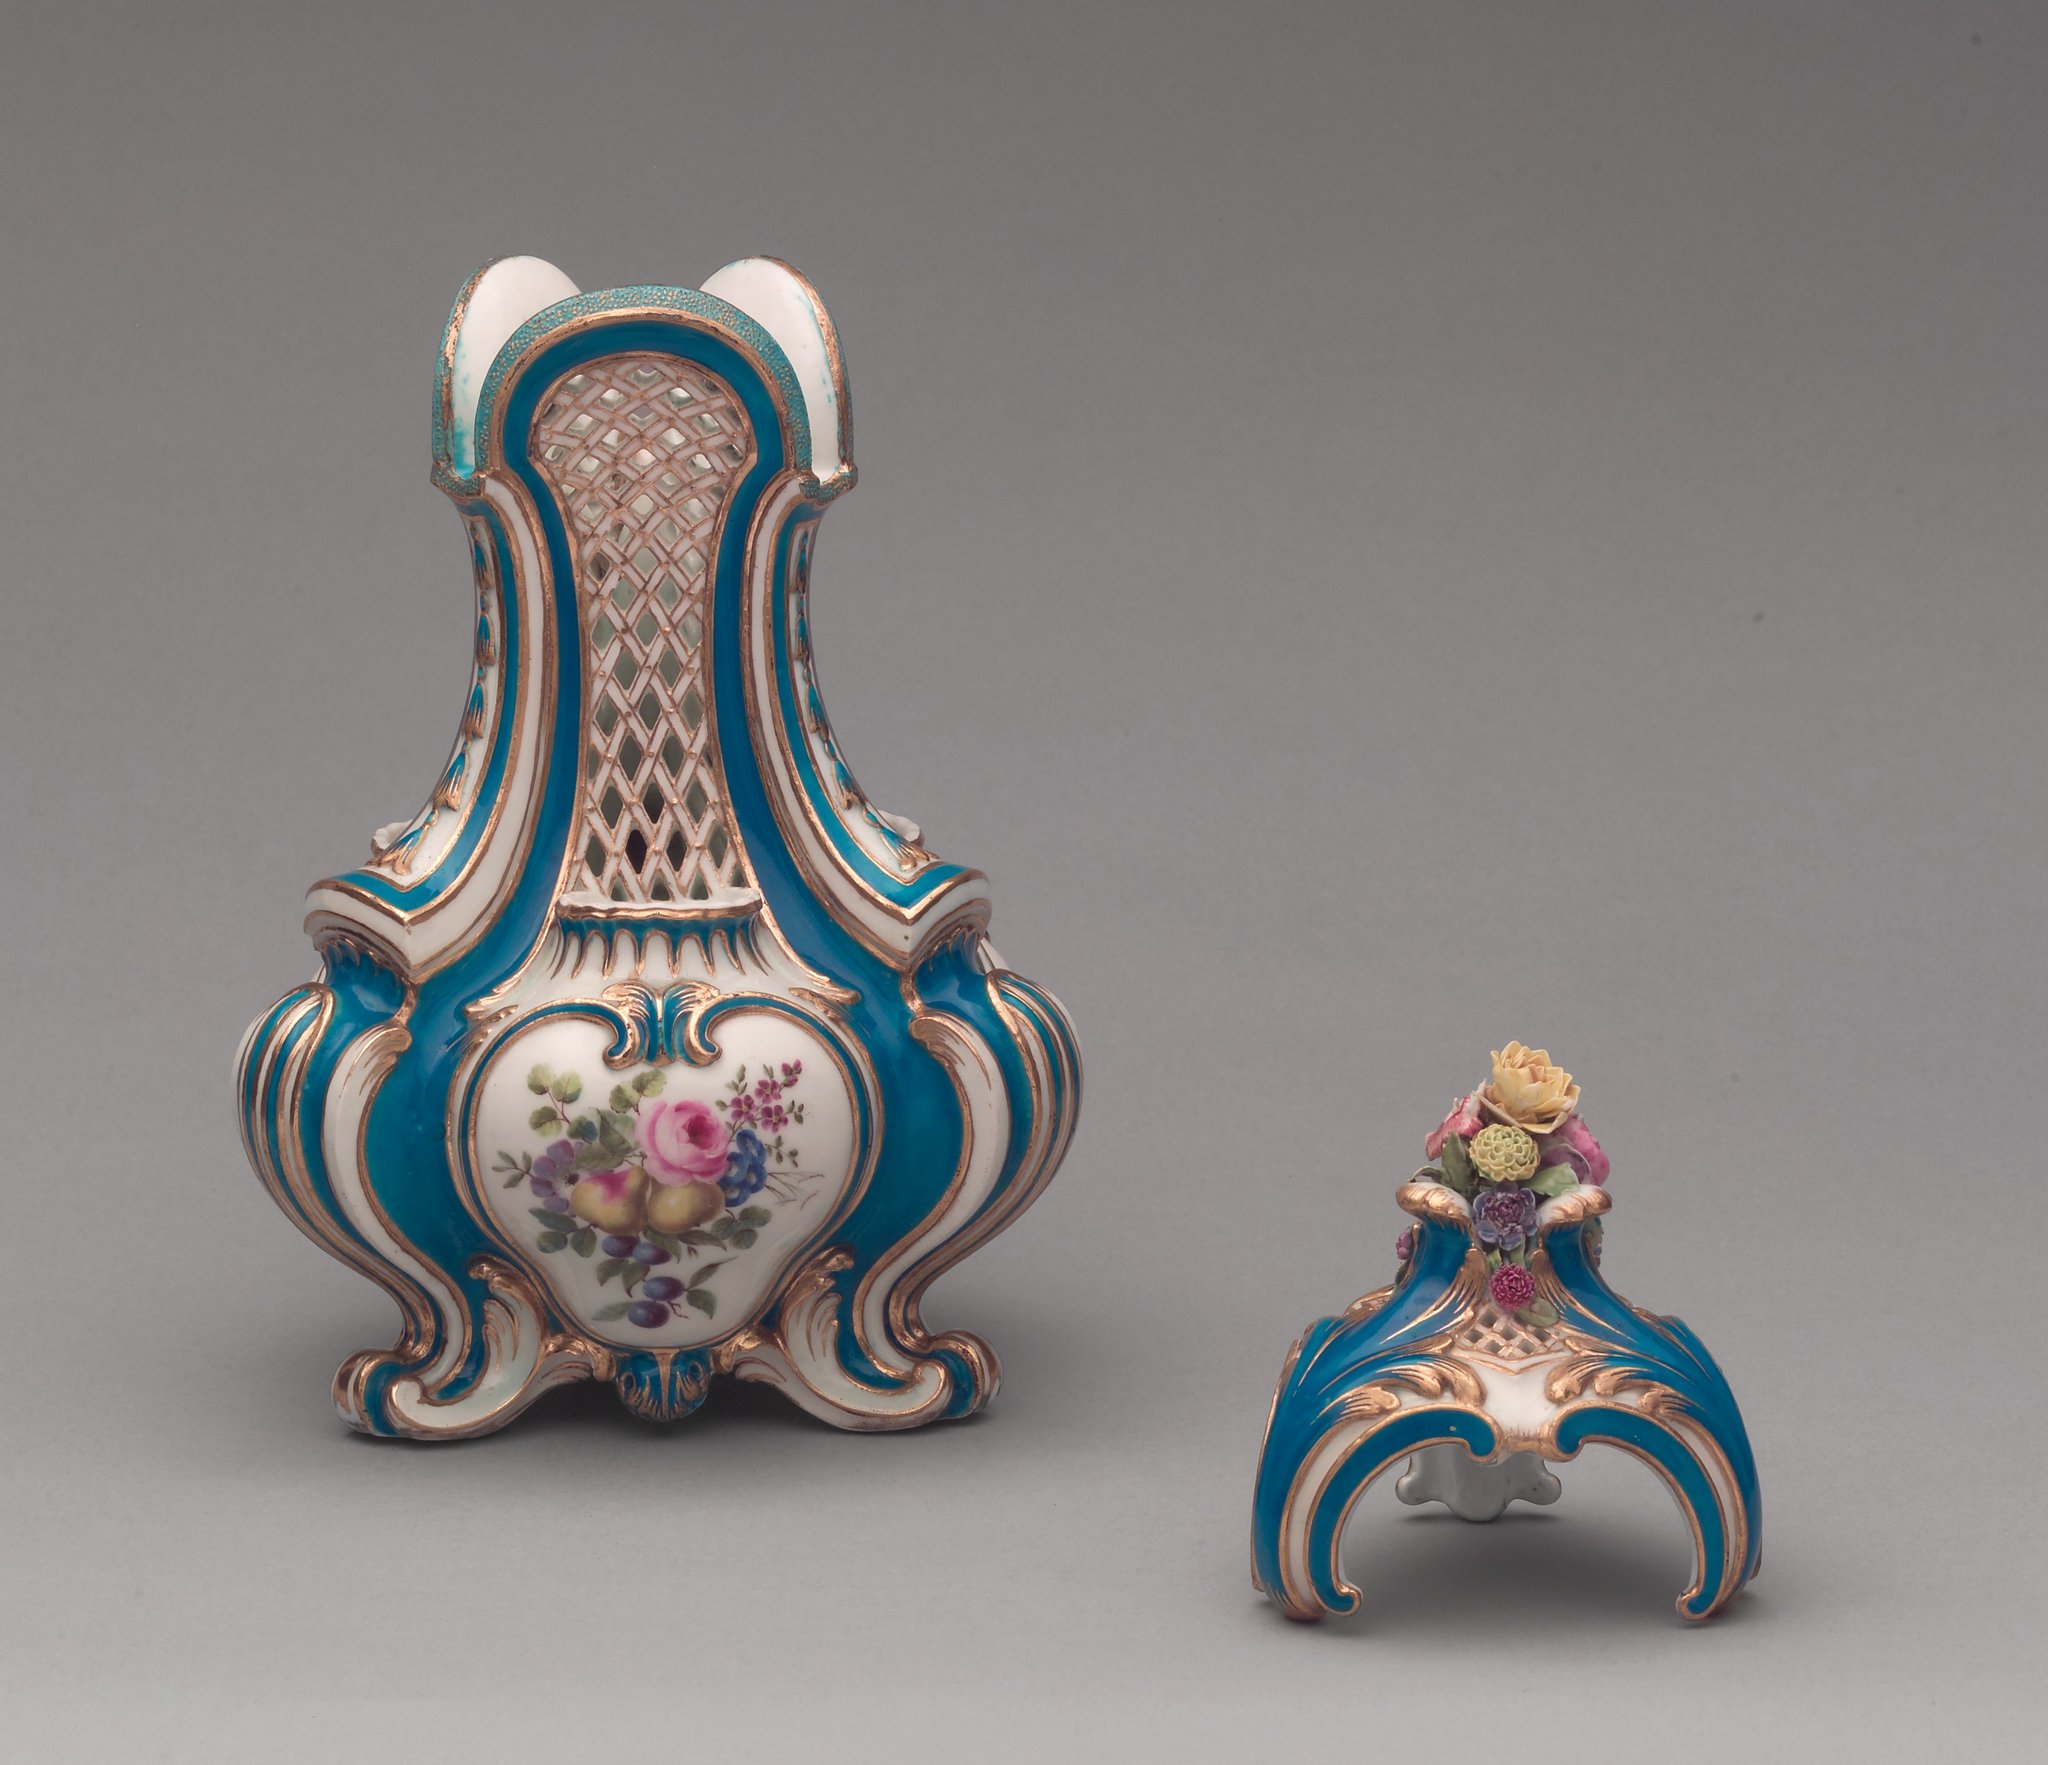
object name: vase with cover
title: Vase with cover (vase pot-pourri triangle) (one of a pair)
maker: sèvres manufactory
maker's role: manufactory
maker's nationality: french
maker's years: 1740-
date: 1761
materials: soft paste porcelain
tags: flowers